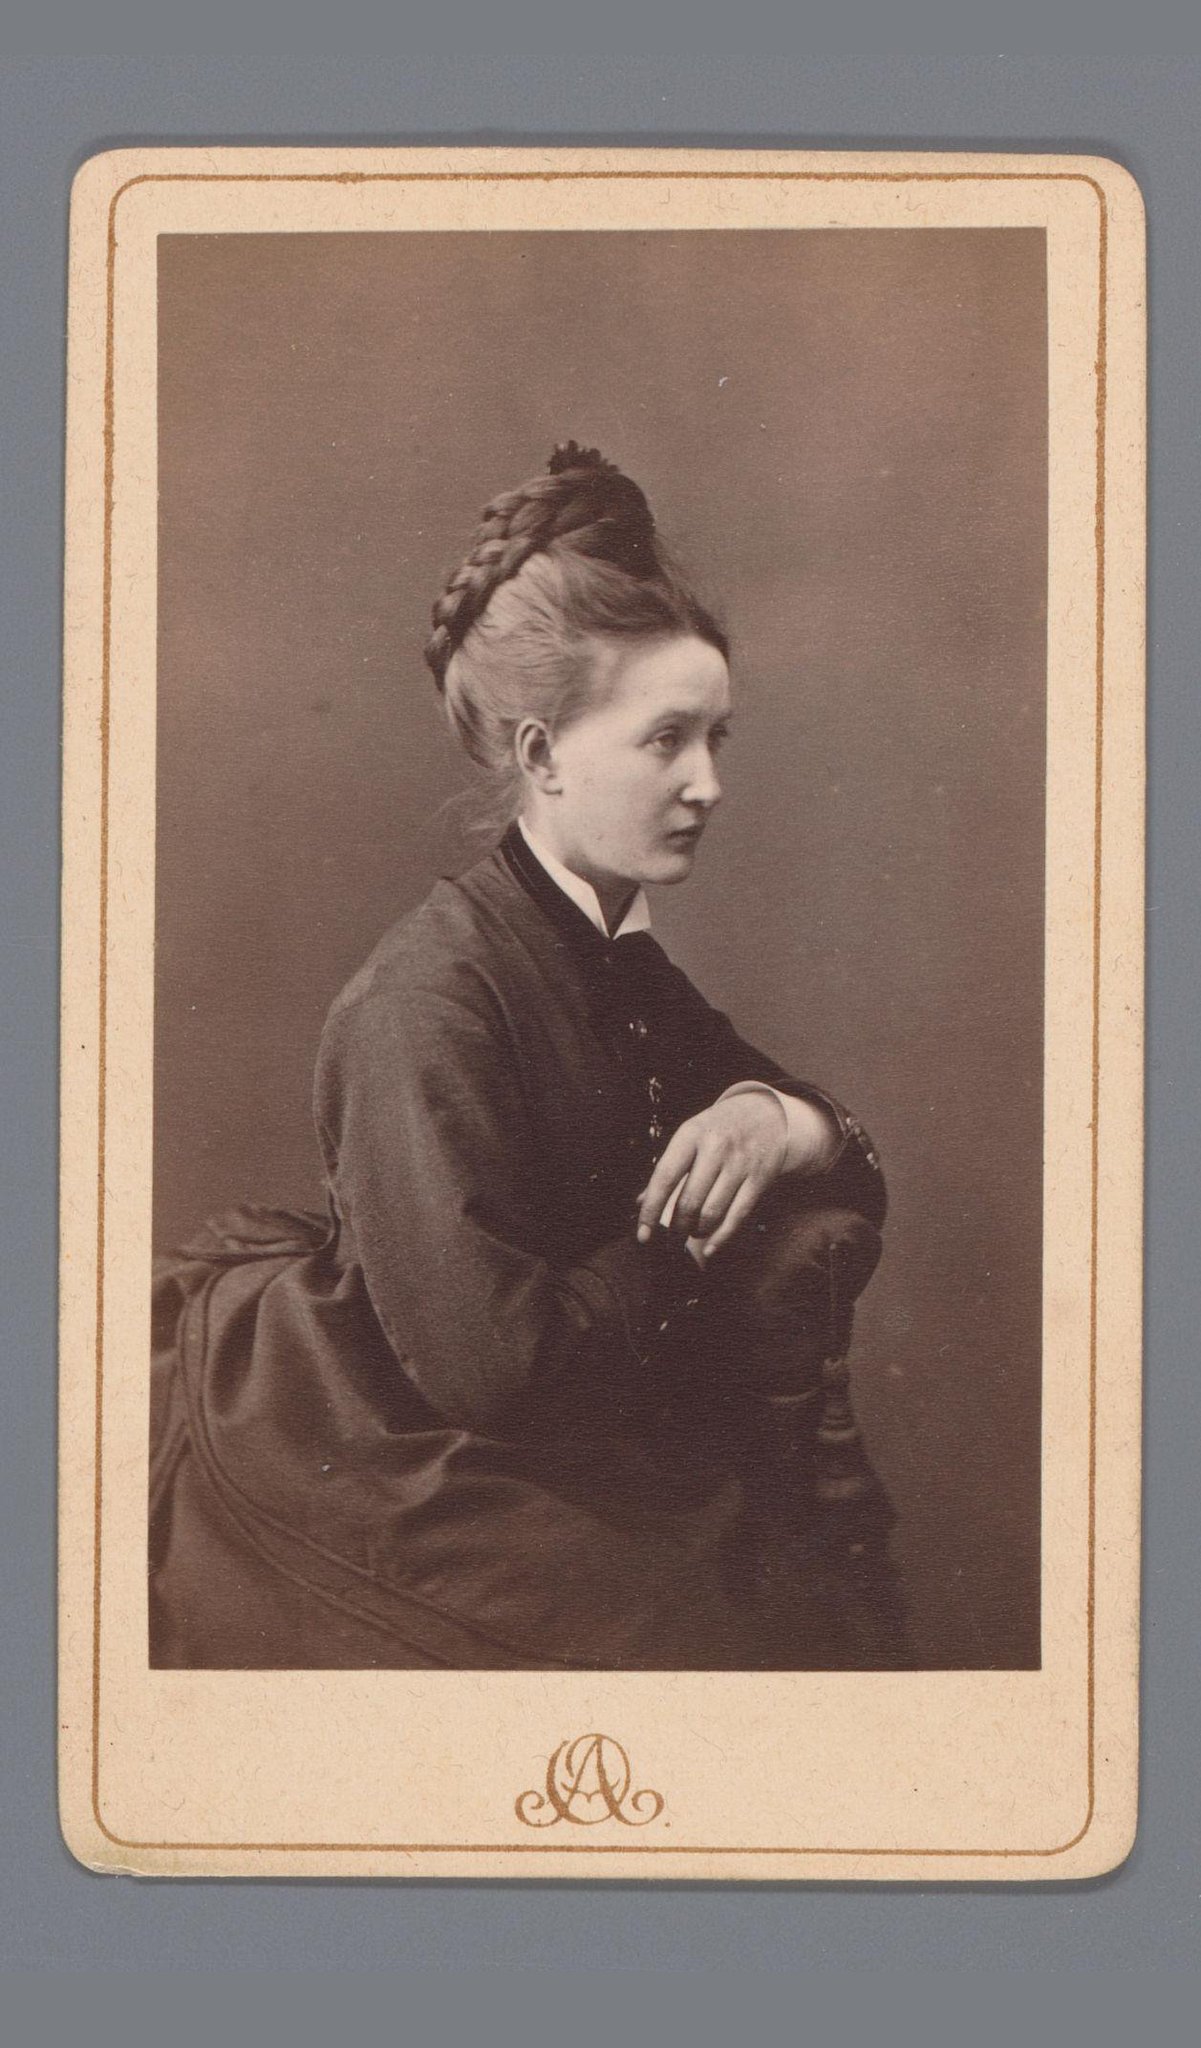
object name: carte de visite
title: Portret van een onbekende zittende vrouw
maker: anna ollson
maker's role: fotograaf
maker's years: 1841-1926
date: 1875-1876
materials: cardboard, paper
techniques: albumen print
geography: karlstad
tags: adolescent, young woman, maiden, historical persons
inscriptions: inscription: ‘Anna Ollsons/ Fotografi-Atelier/ KARLSTAD’, monogram: ‘AO’